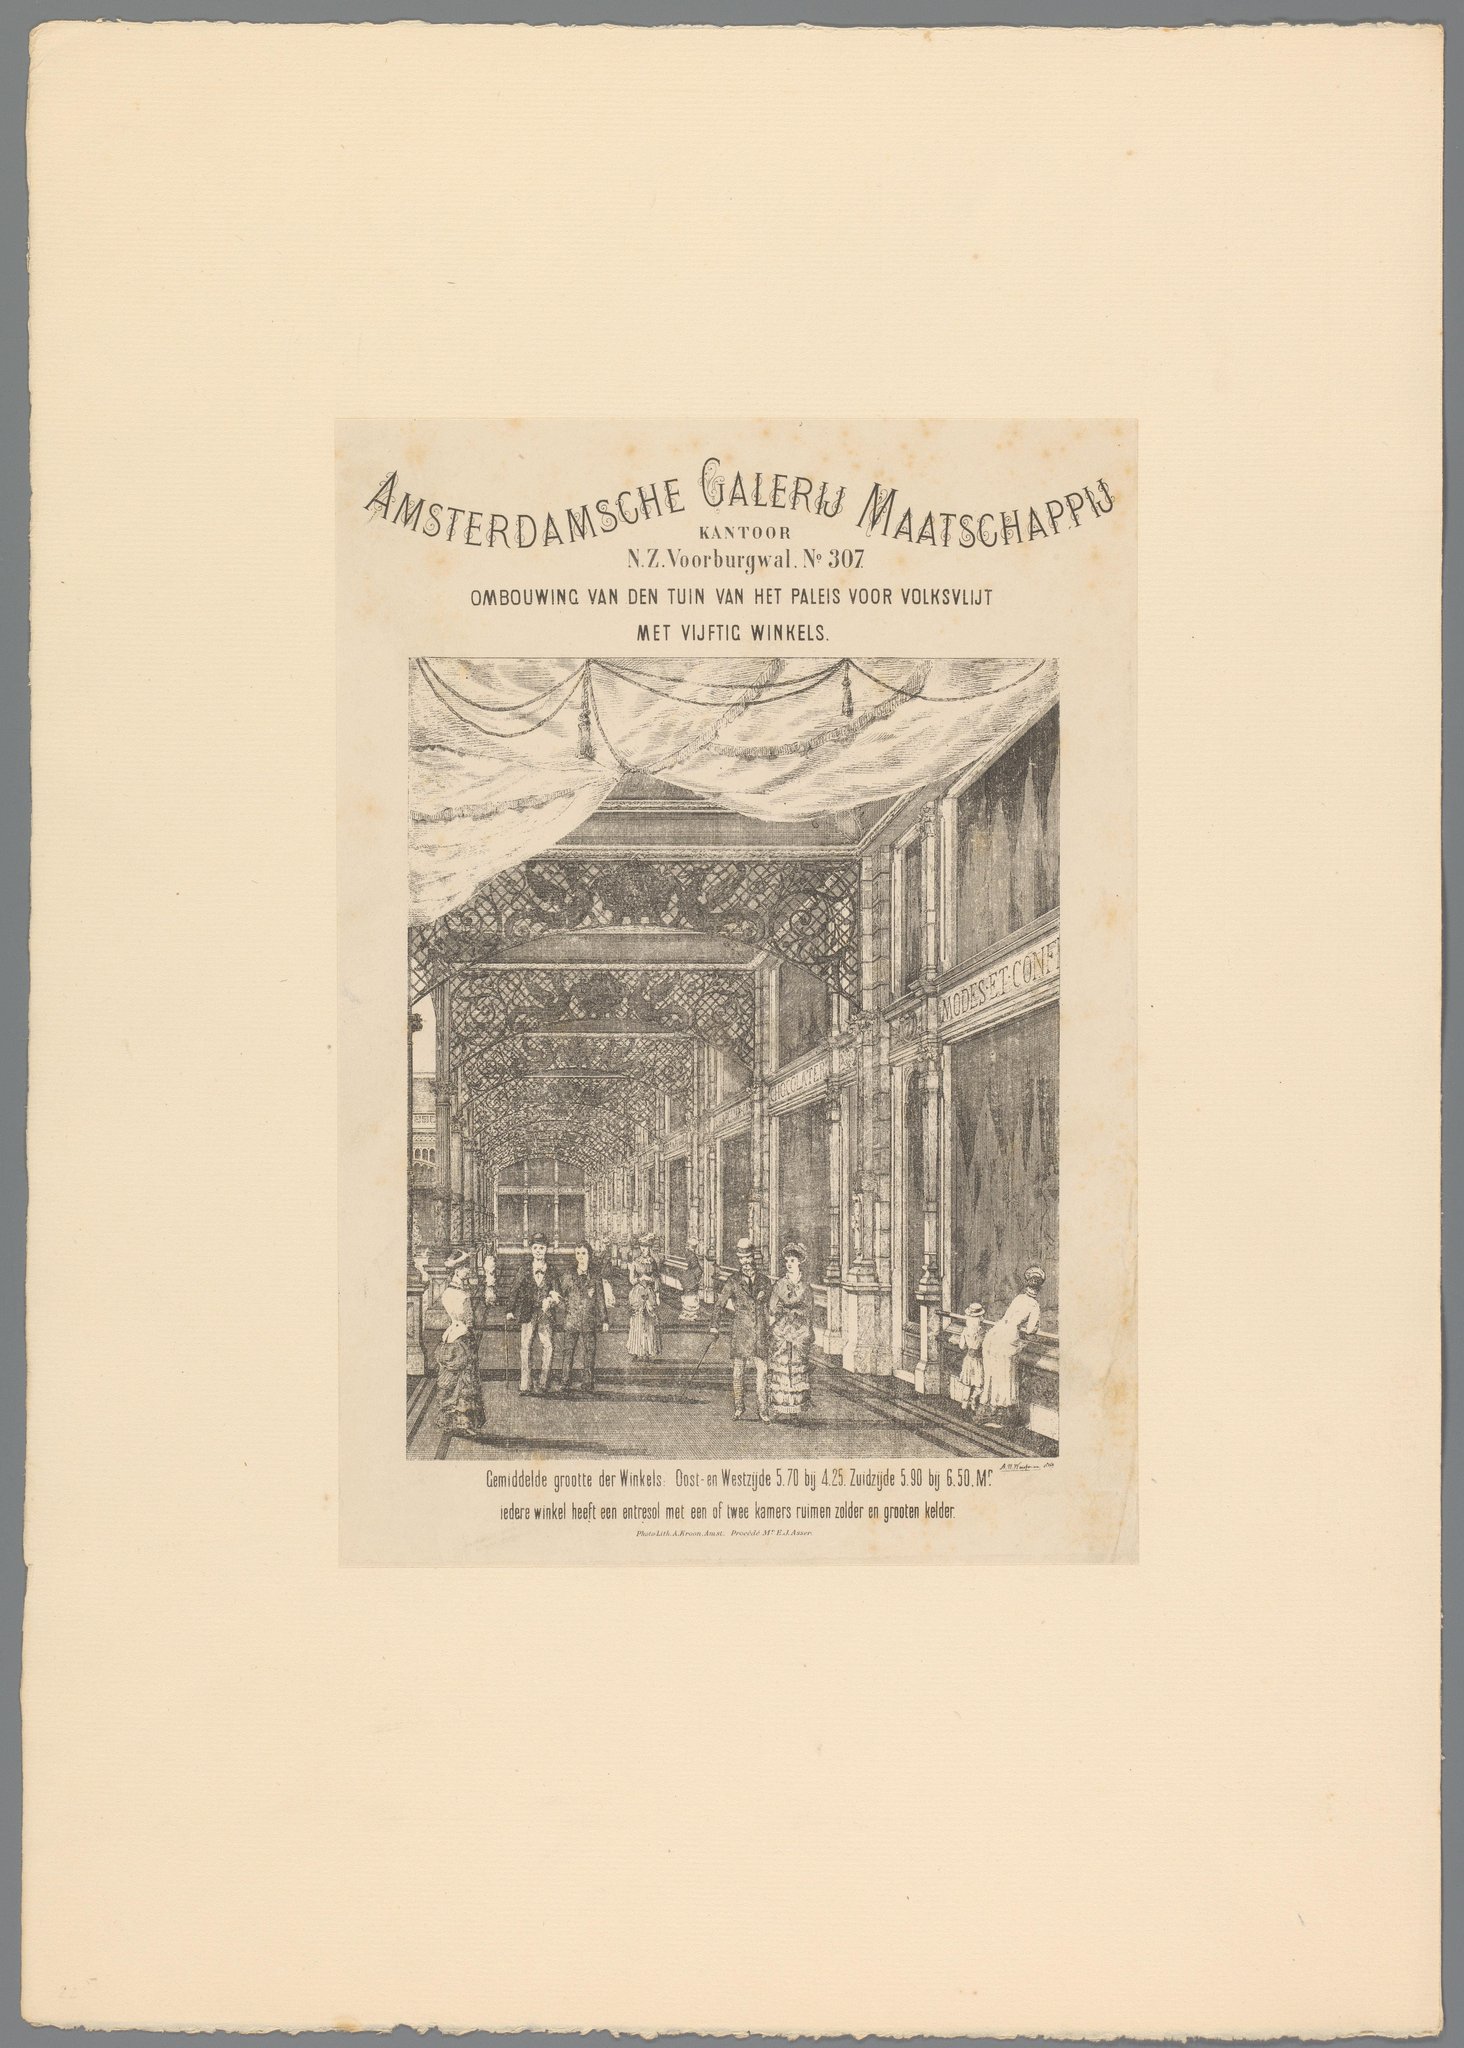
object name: photomechanical print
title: Winkelgalerij in de voormalige tuin van het Paleis voor Volksvlijt, Amsterdam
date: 1875-1881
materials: paper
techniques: photolithograph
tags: shop-window, show-window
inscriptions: inscription: ‘Gemiddelde grootte der Winkels: Oost- en Westzijde 5.70 bij 4.25. Zuidzijde 5.90 bij 6.50 Mr./ iedere winkel heeft een entresol met een of twee kamers ruimen zolder en grooten kelder.’, inscription: ‘Amsterdamse Galerij Maatschappij/ KANTOOR/ N.Z. Voorburgwal. No. 307.’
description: Aankondiging van de bouw van een winkelgalerij in de tuin van het Paleis voor Volksvlijt, tussen Oosteinde en Westeinde.